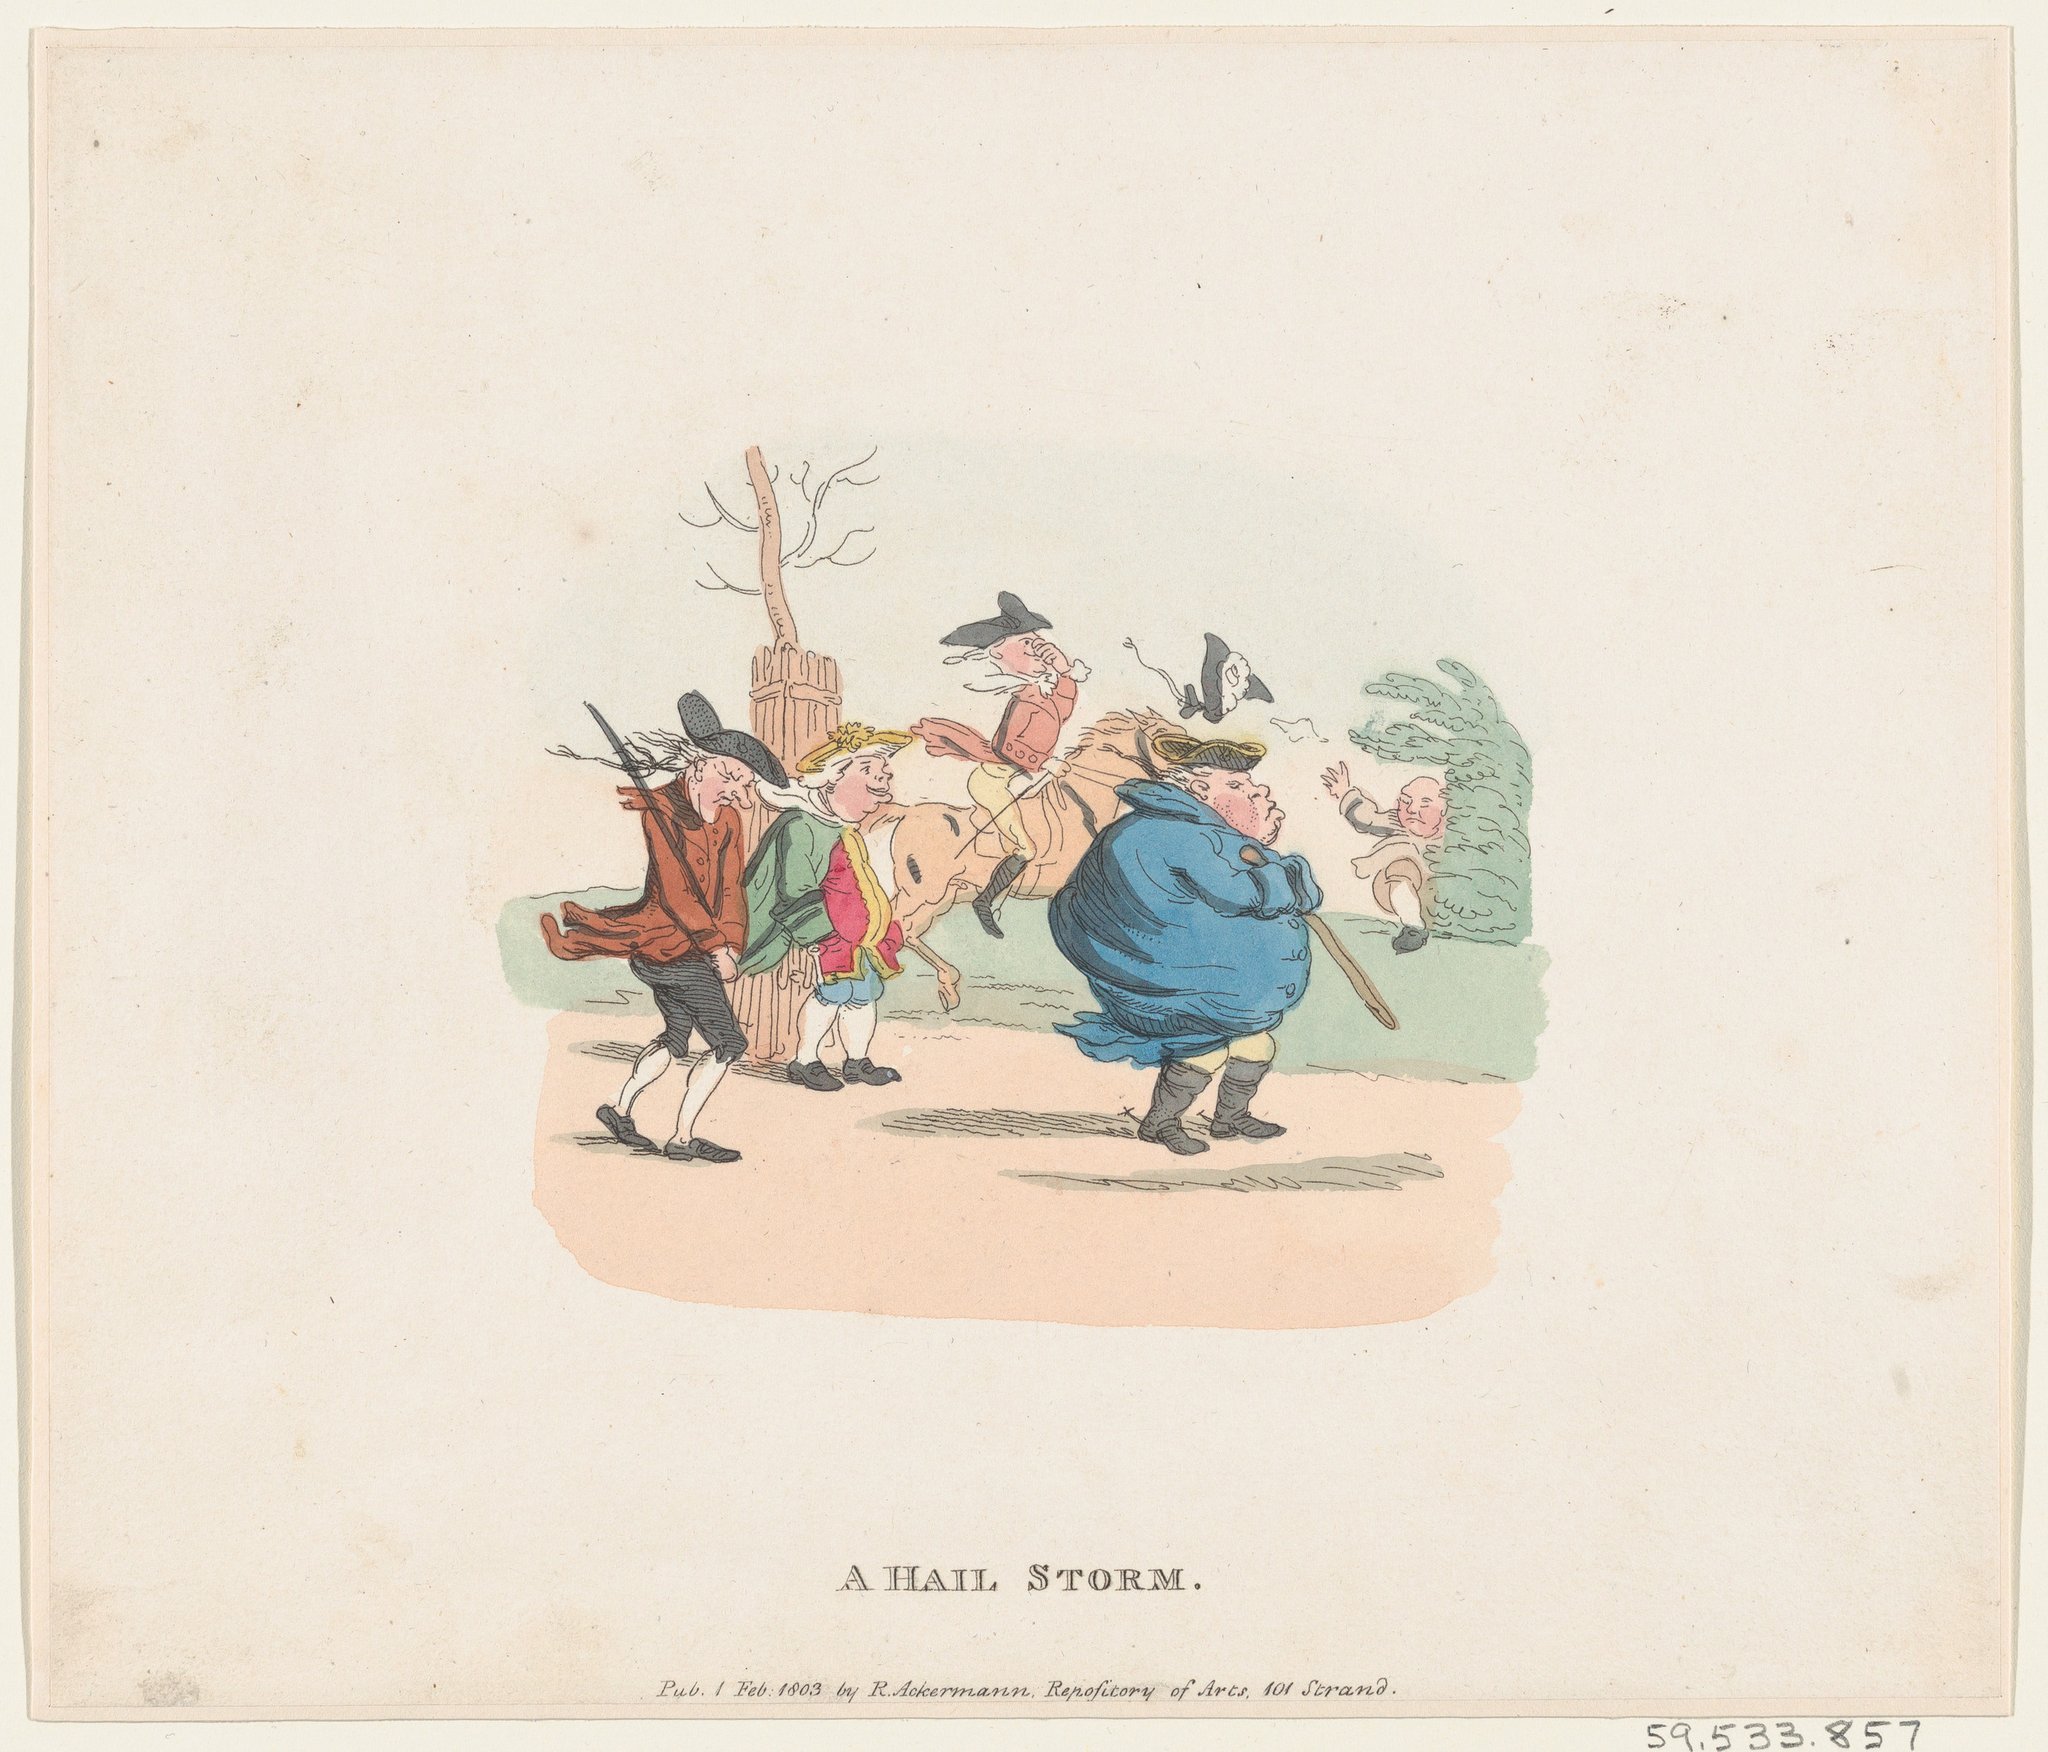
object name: print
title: A Hail Storm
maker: henry william bunbury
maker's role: artist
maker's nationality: british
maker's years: 1750-1811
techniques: etching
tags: satire,men,horses